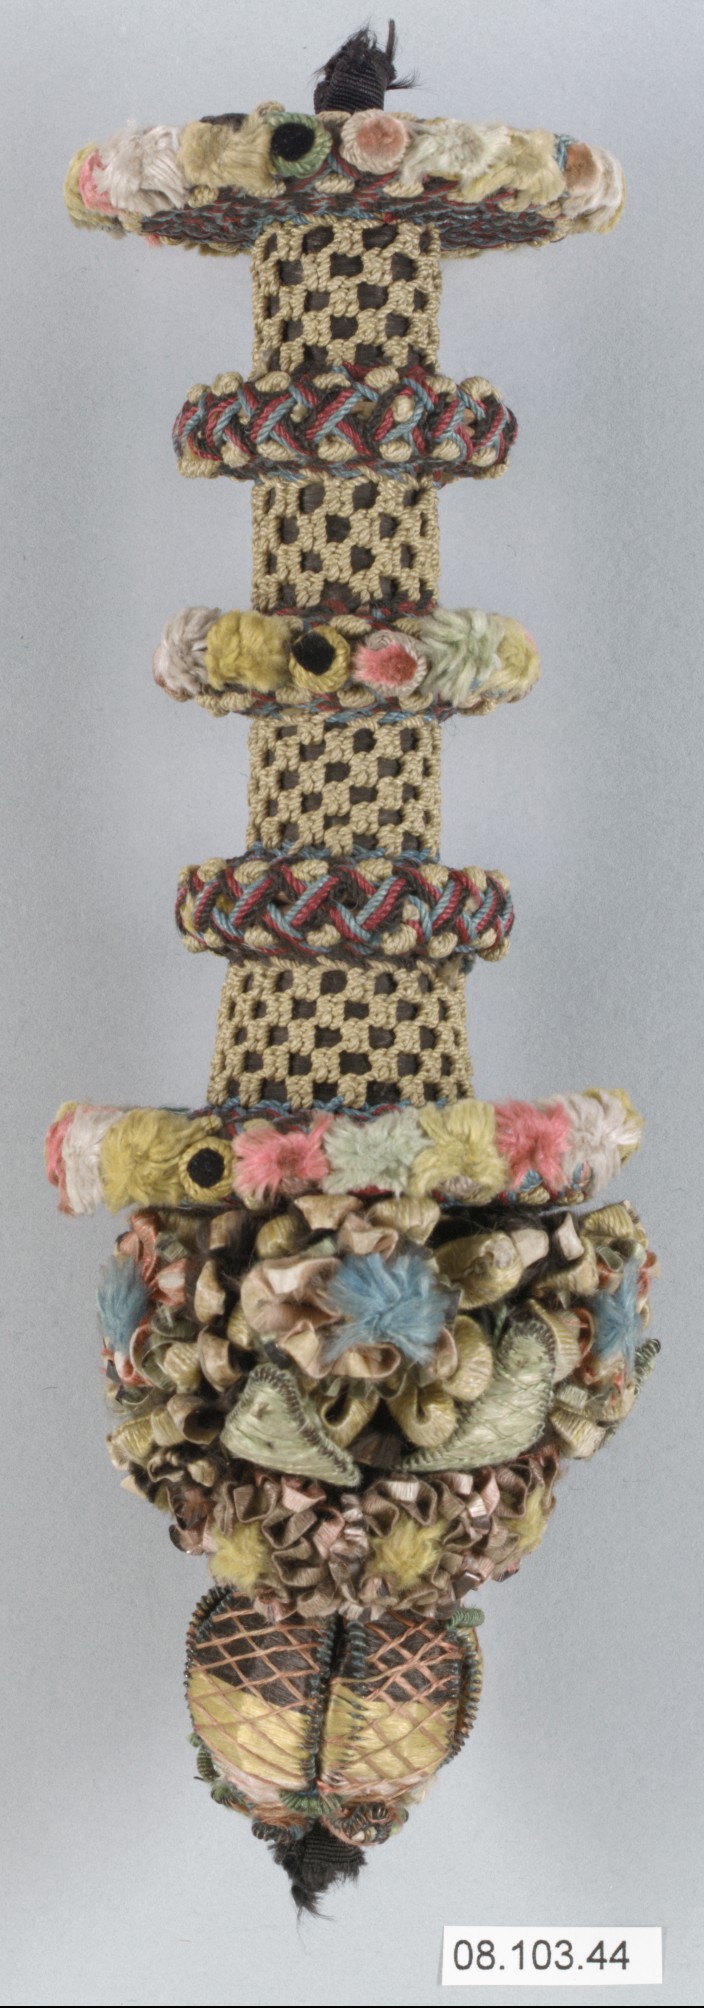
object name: tassel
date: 1701-1800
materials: metal thread, silk